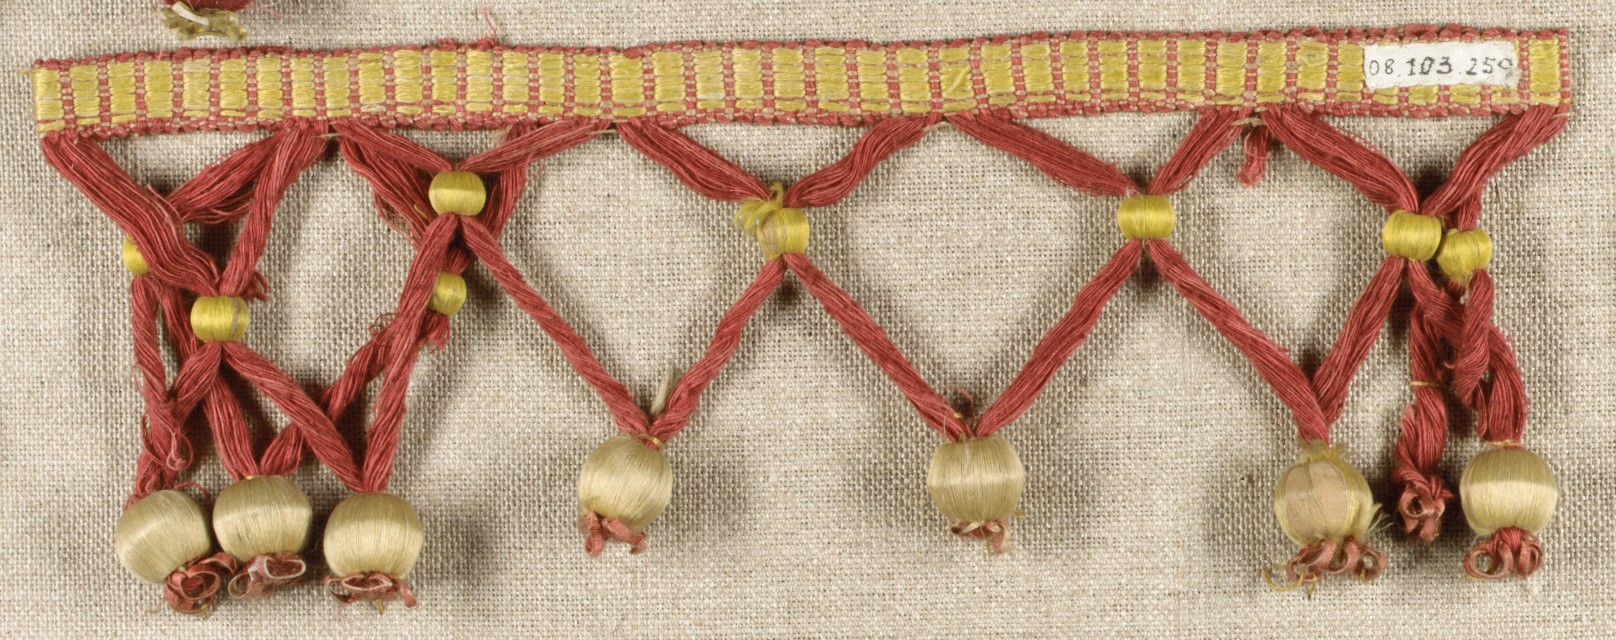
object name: fringe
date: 1801-1900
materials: cotton, silk